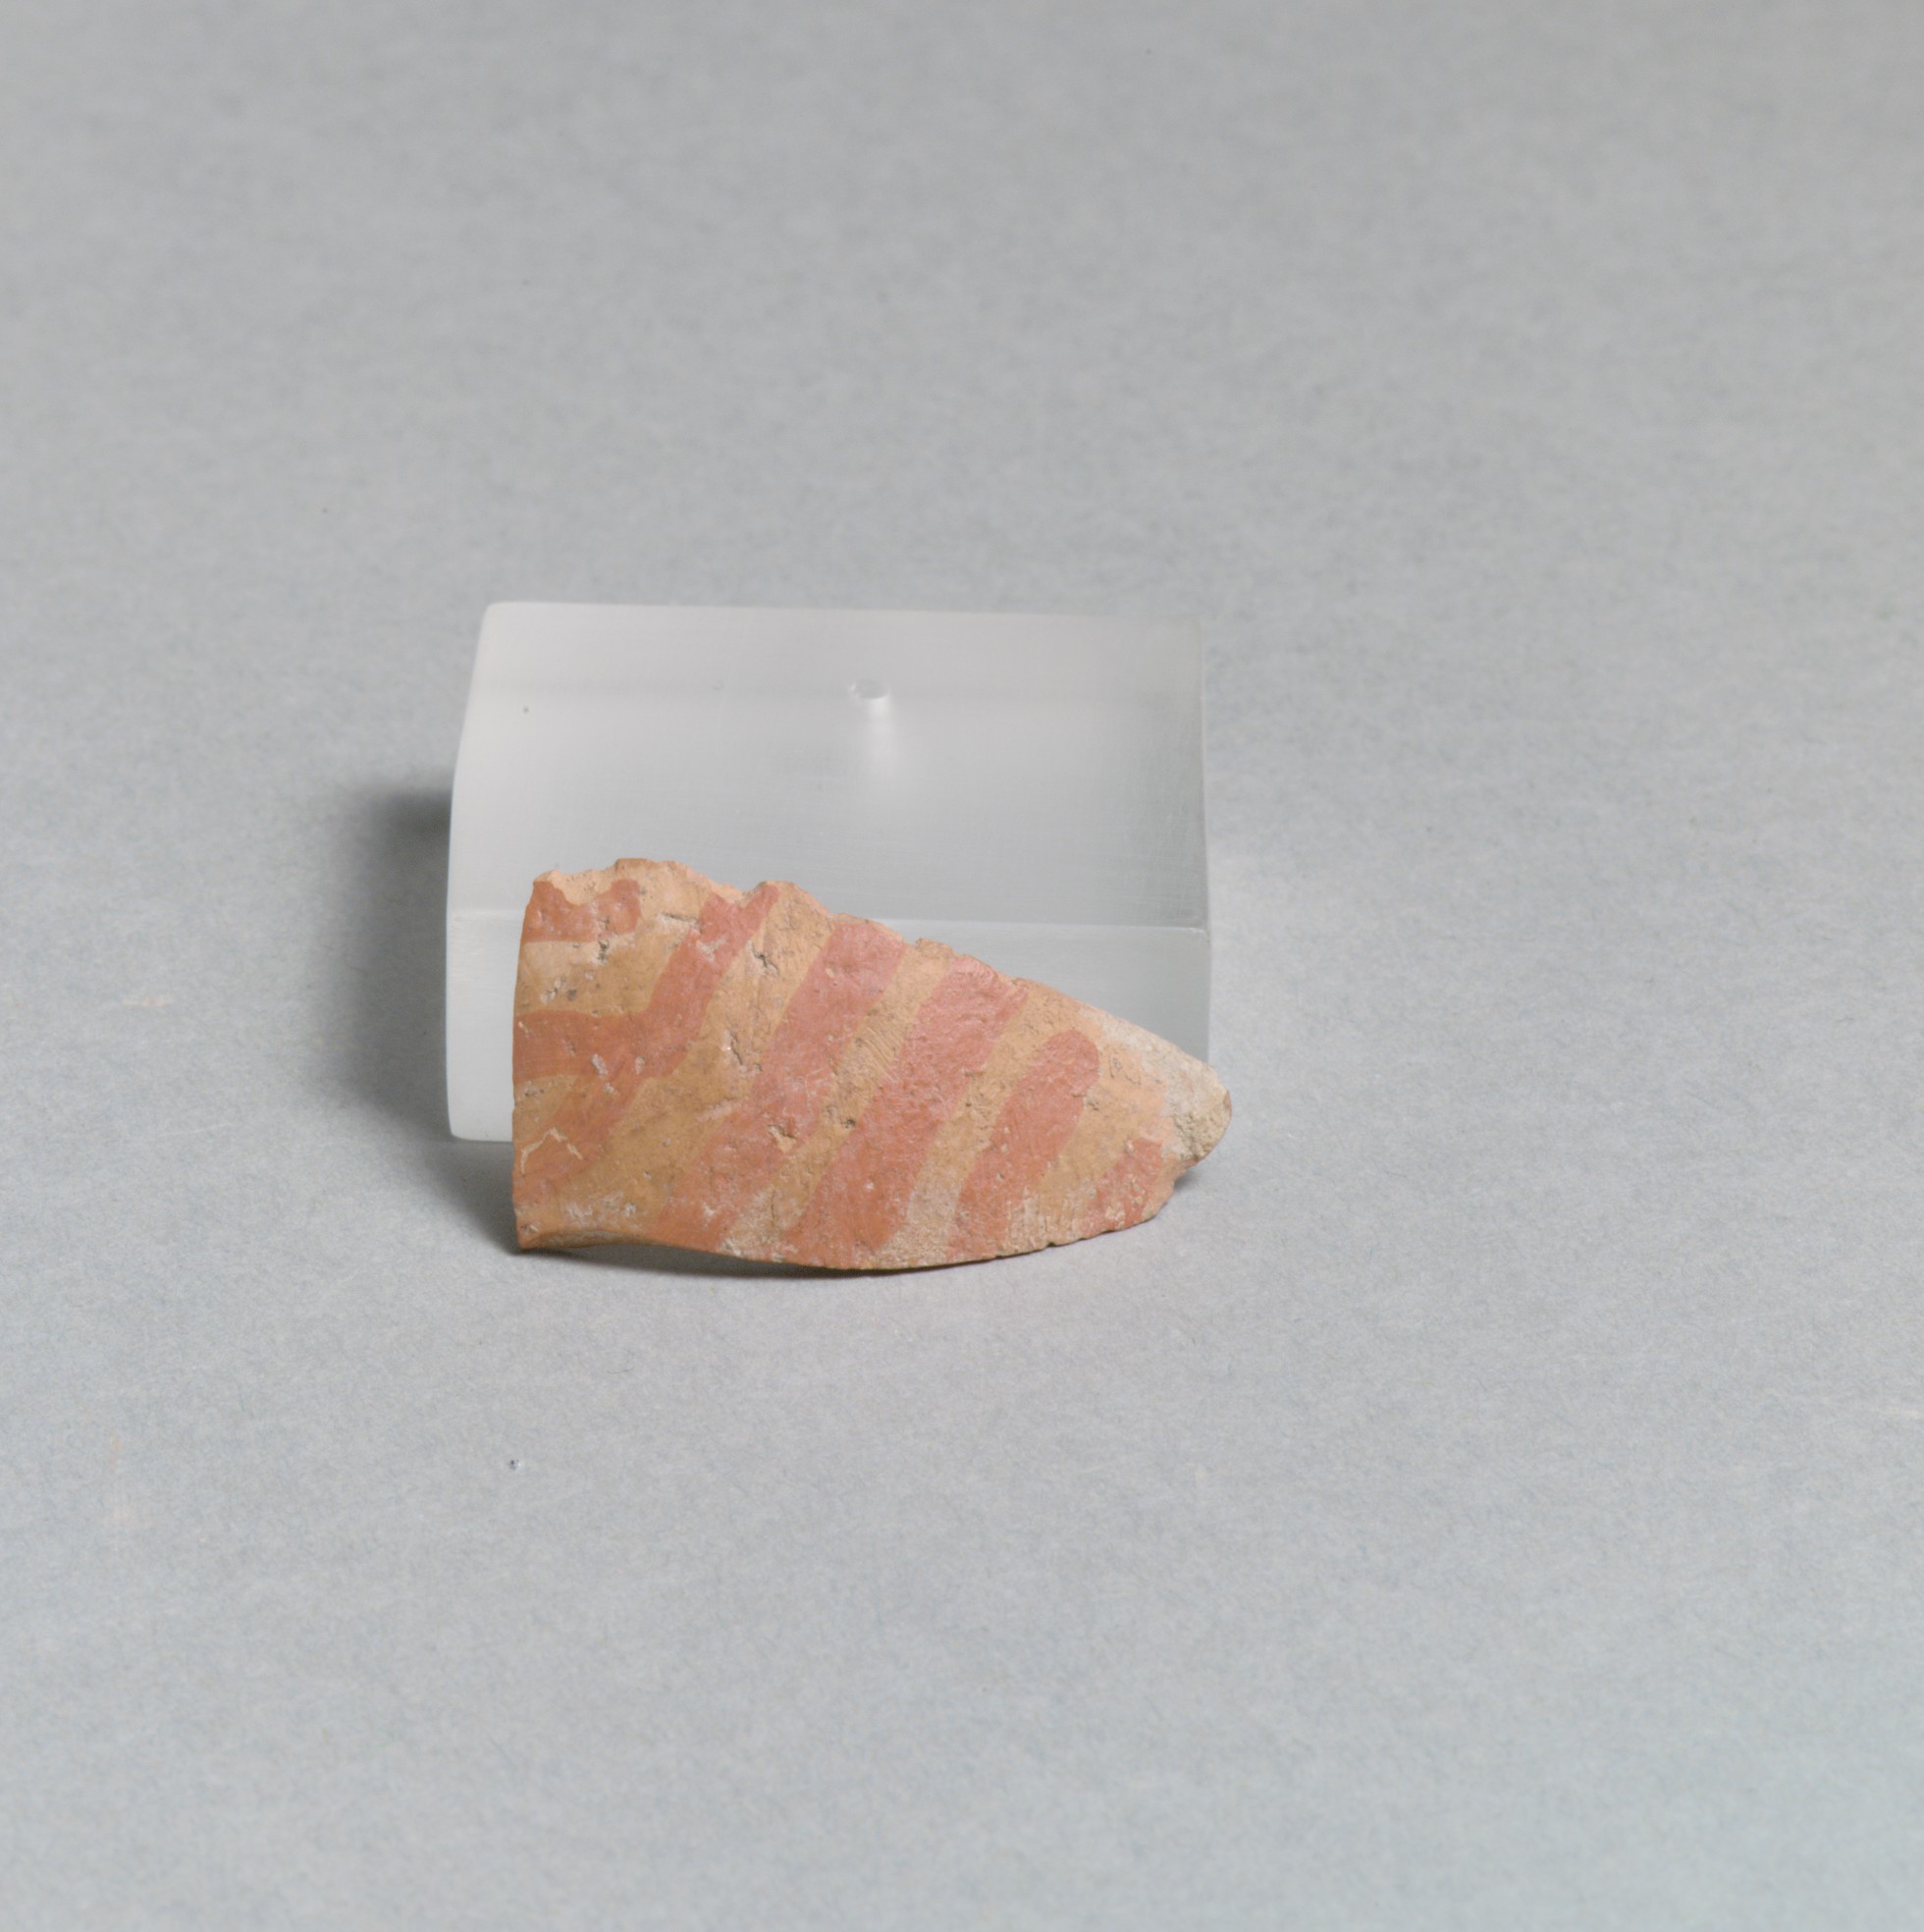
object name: vase fragment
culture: greek, laconian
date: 2000-1550 BCE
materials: terracotta